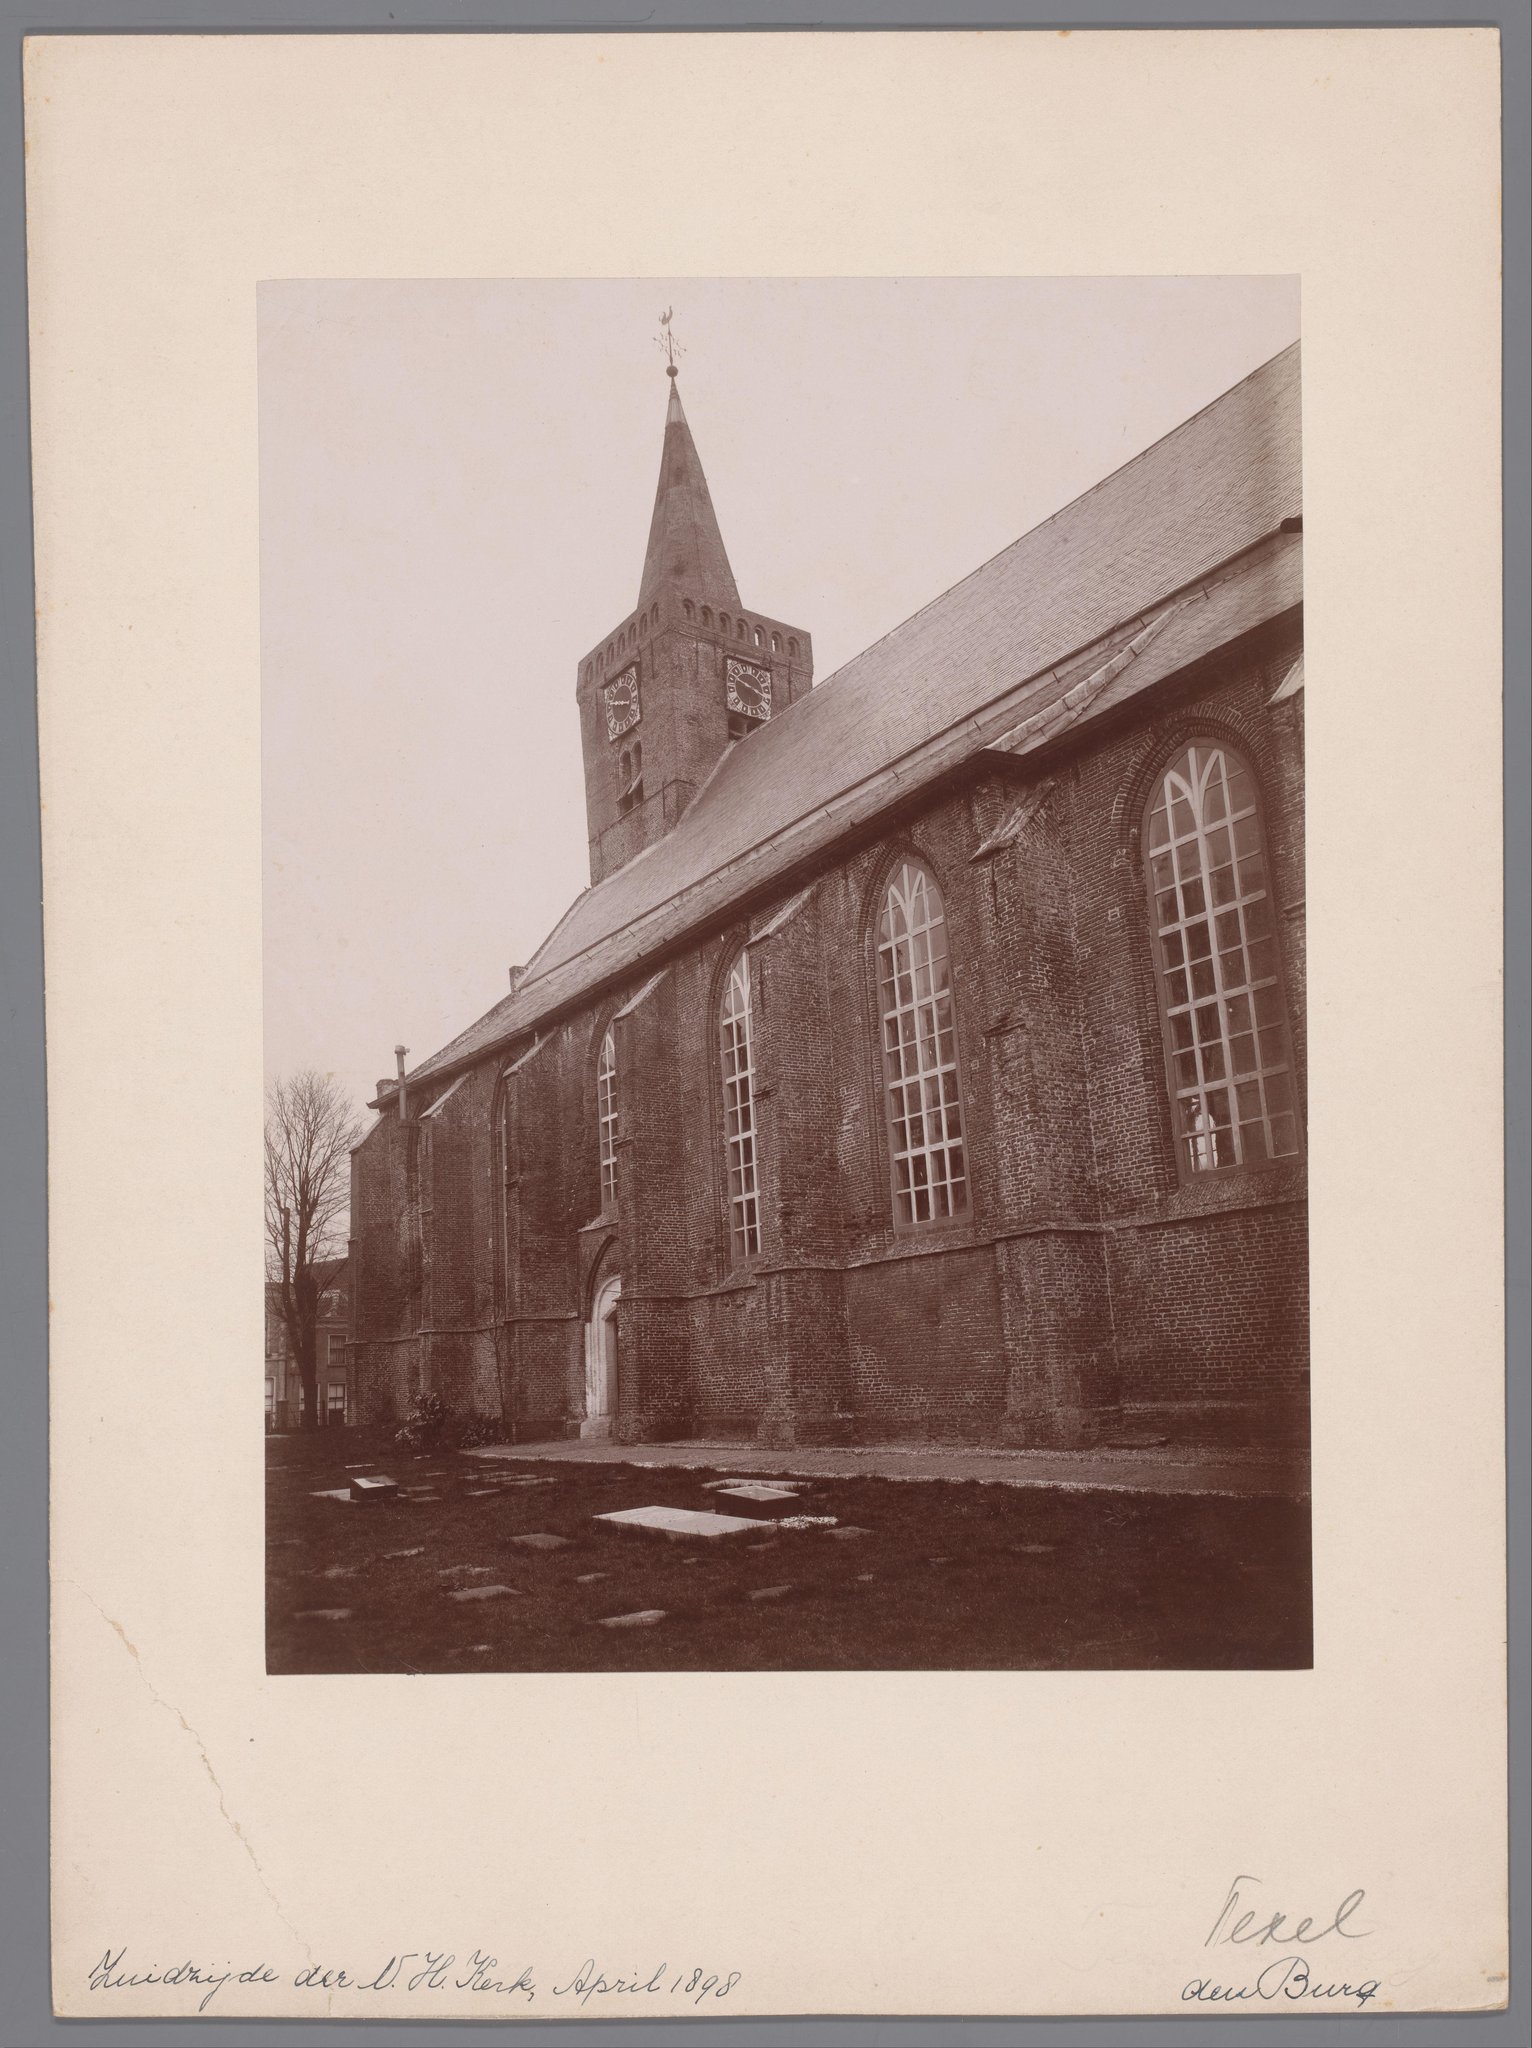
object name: photograph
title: Gezicht op de Burghtkerk te Den Burg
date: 1898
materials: cardboard, photographic support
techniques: gelatin silver print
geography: den burg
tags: church (exterior)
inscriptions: annotation: ‘Texel, den Burg’, annotation: ‘Zuidzijde der N.H. Kerk, april 1898’, annotation: ‘Texel - den Burg (N.H.)/ Zuidzijde der N.H. kerk/ april 1898’